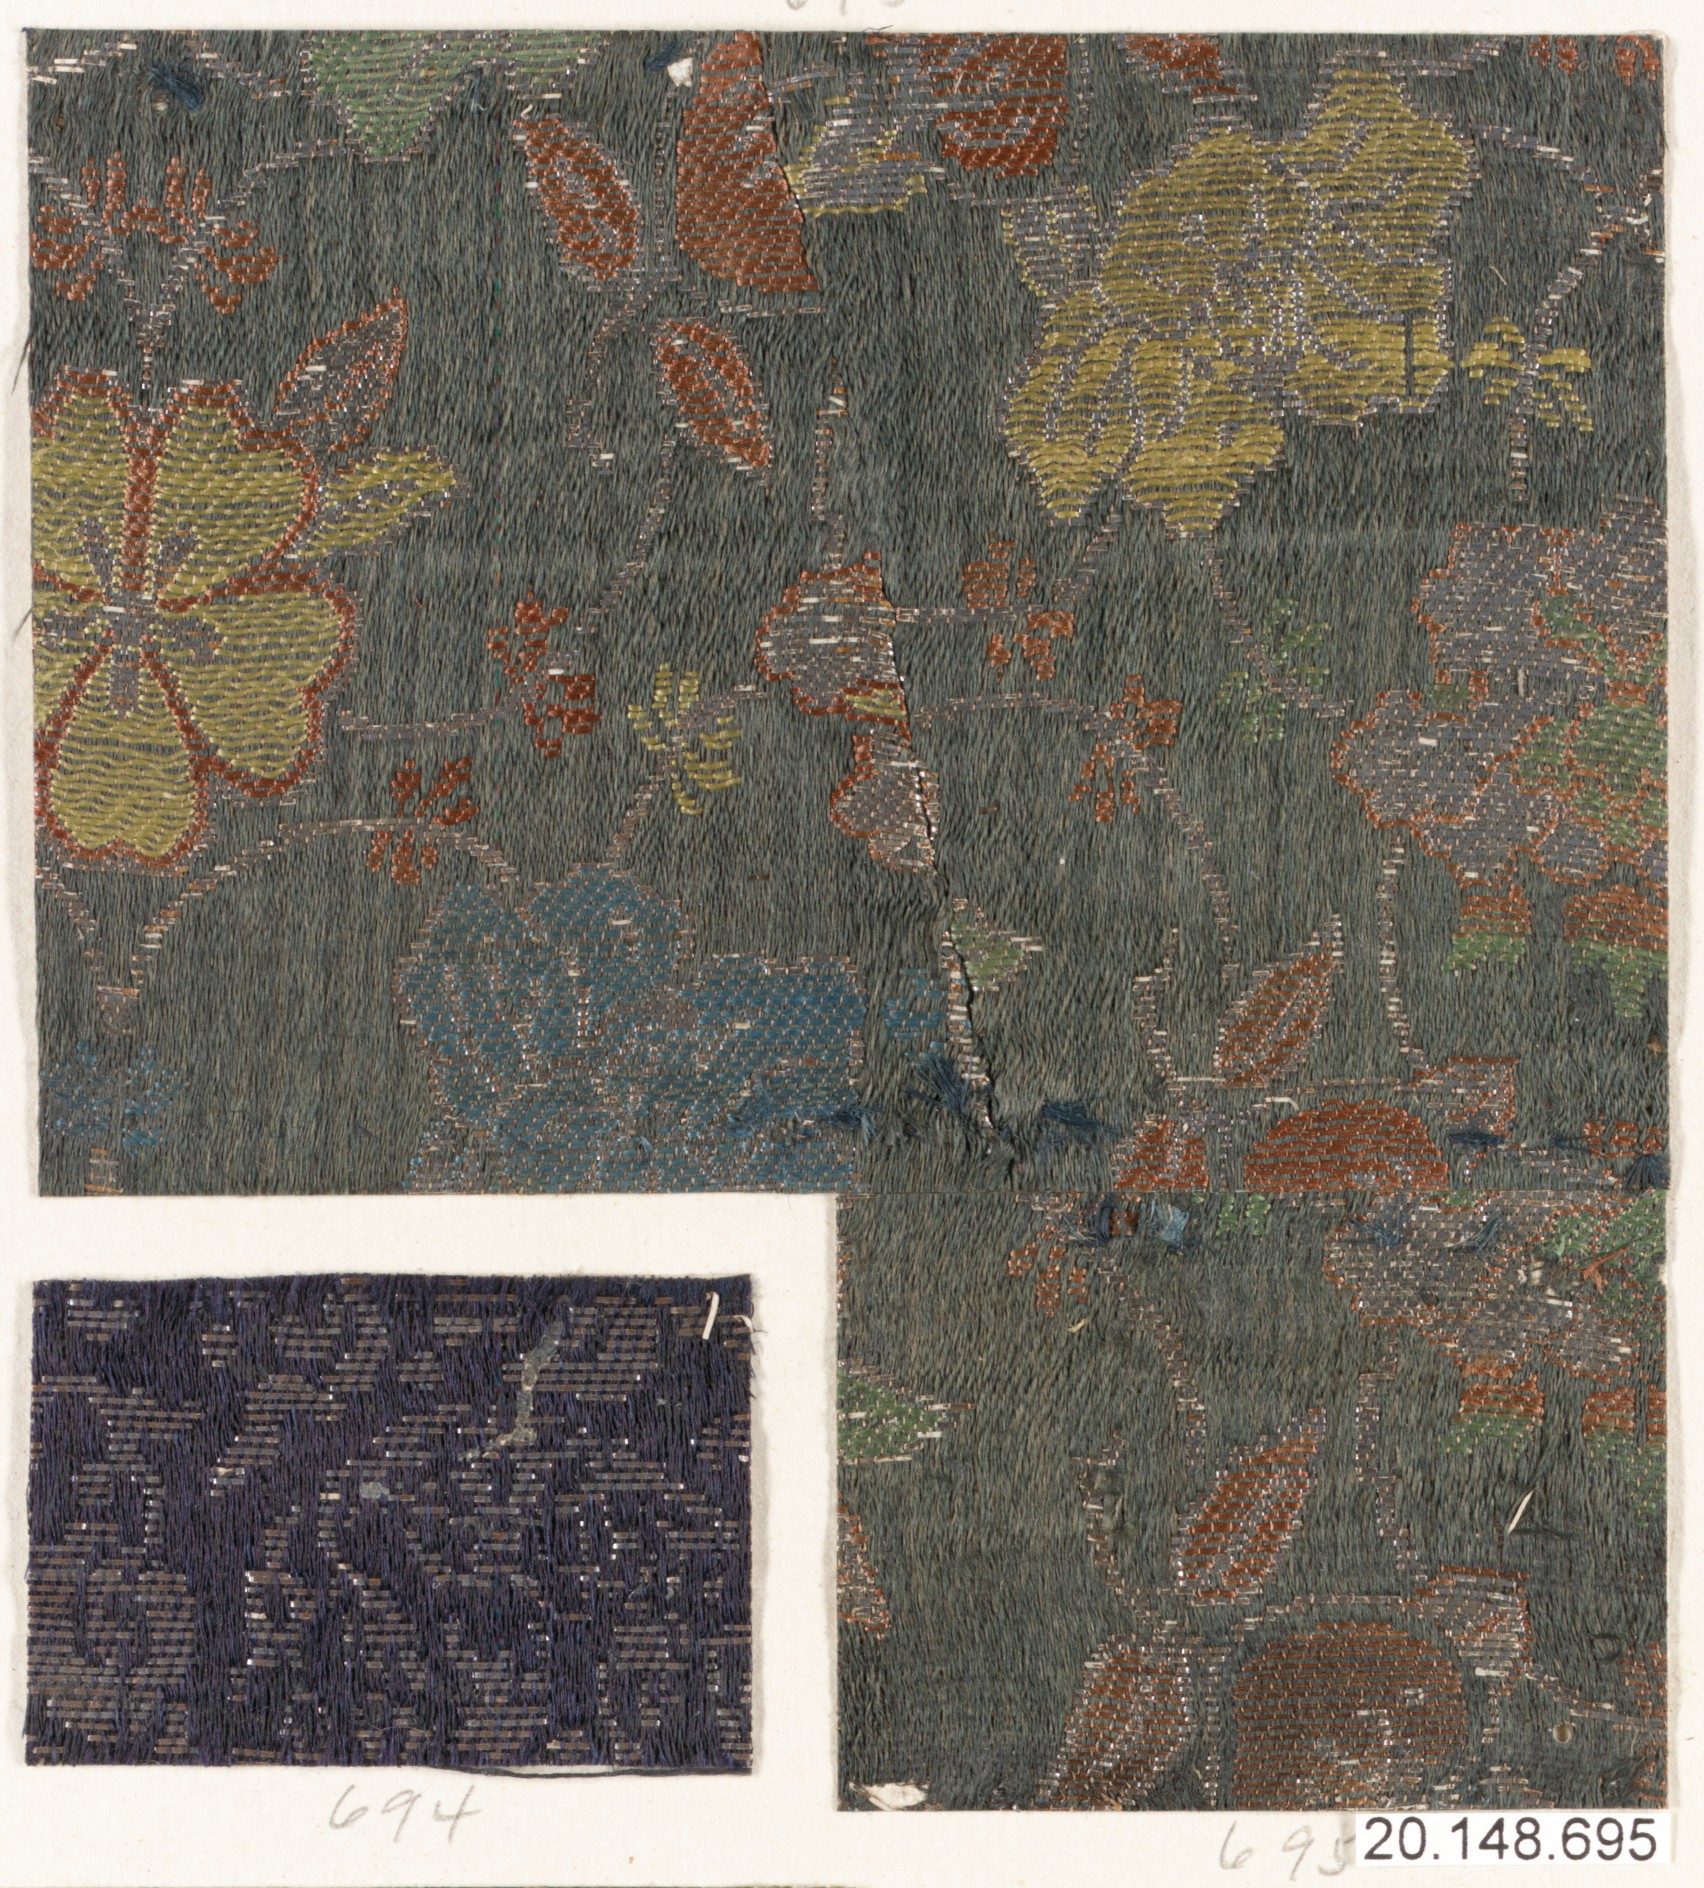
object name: piece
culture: japanese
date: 1601-1700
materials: silk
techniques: compound weave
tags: flowers,leaves